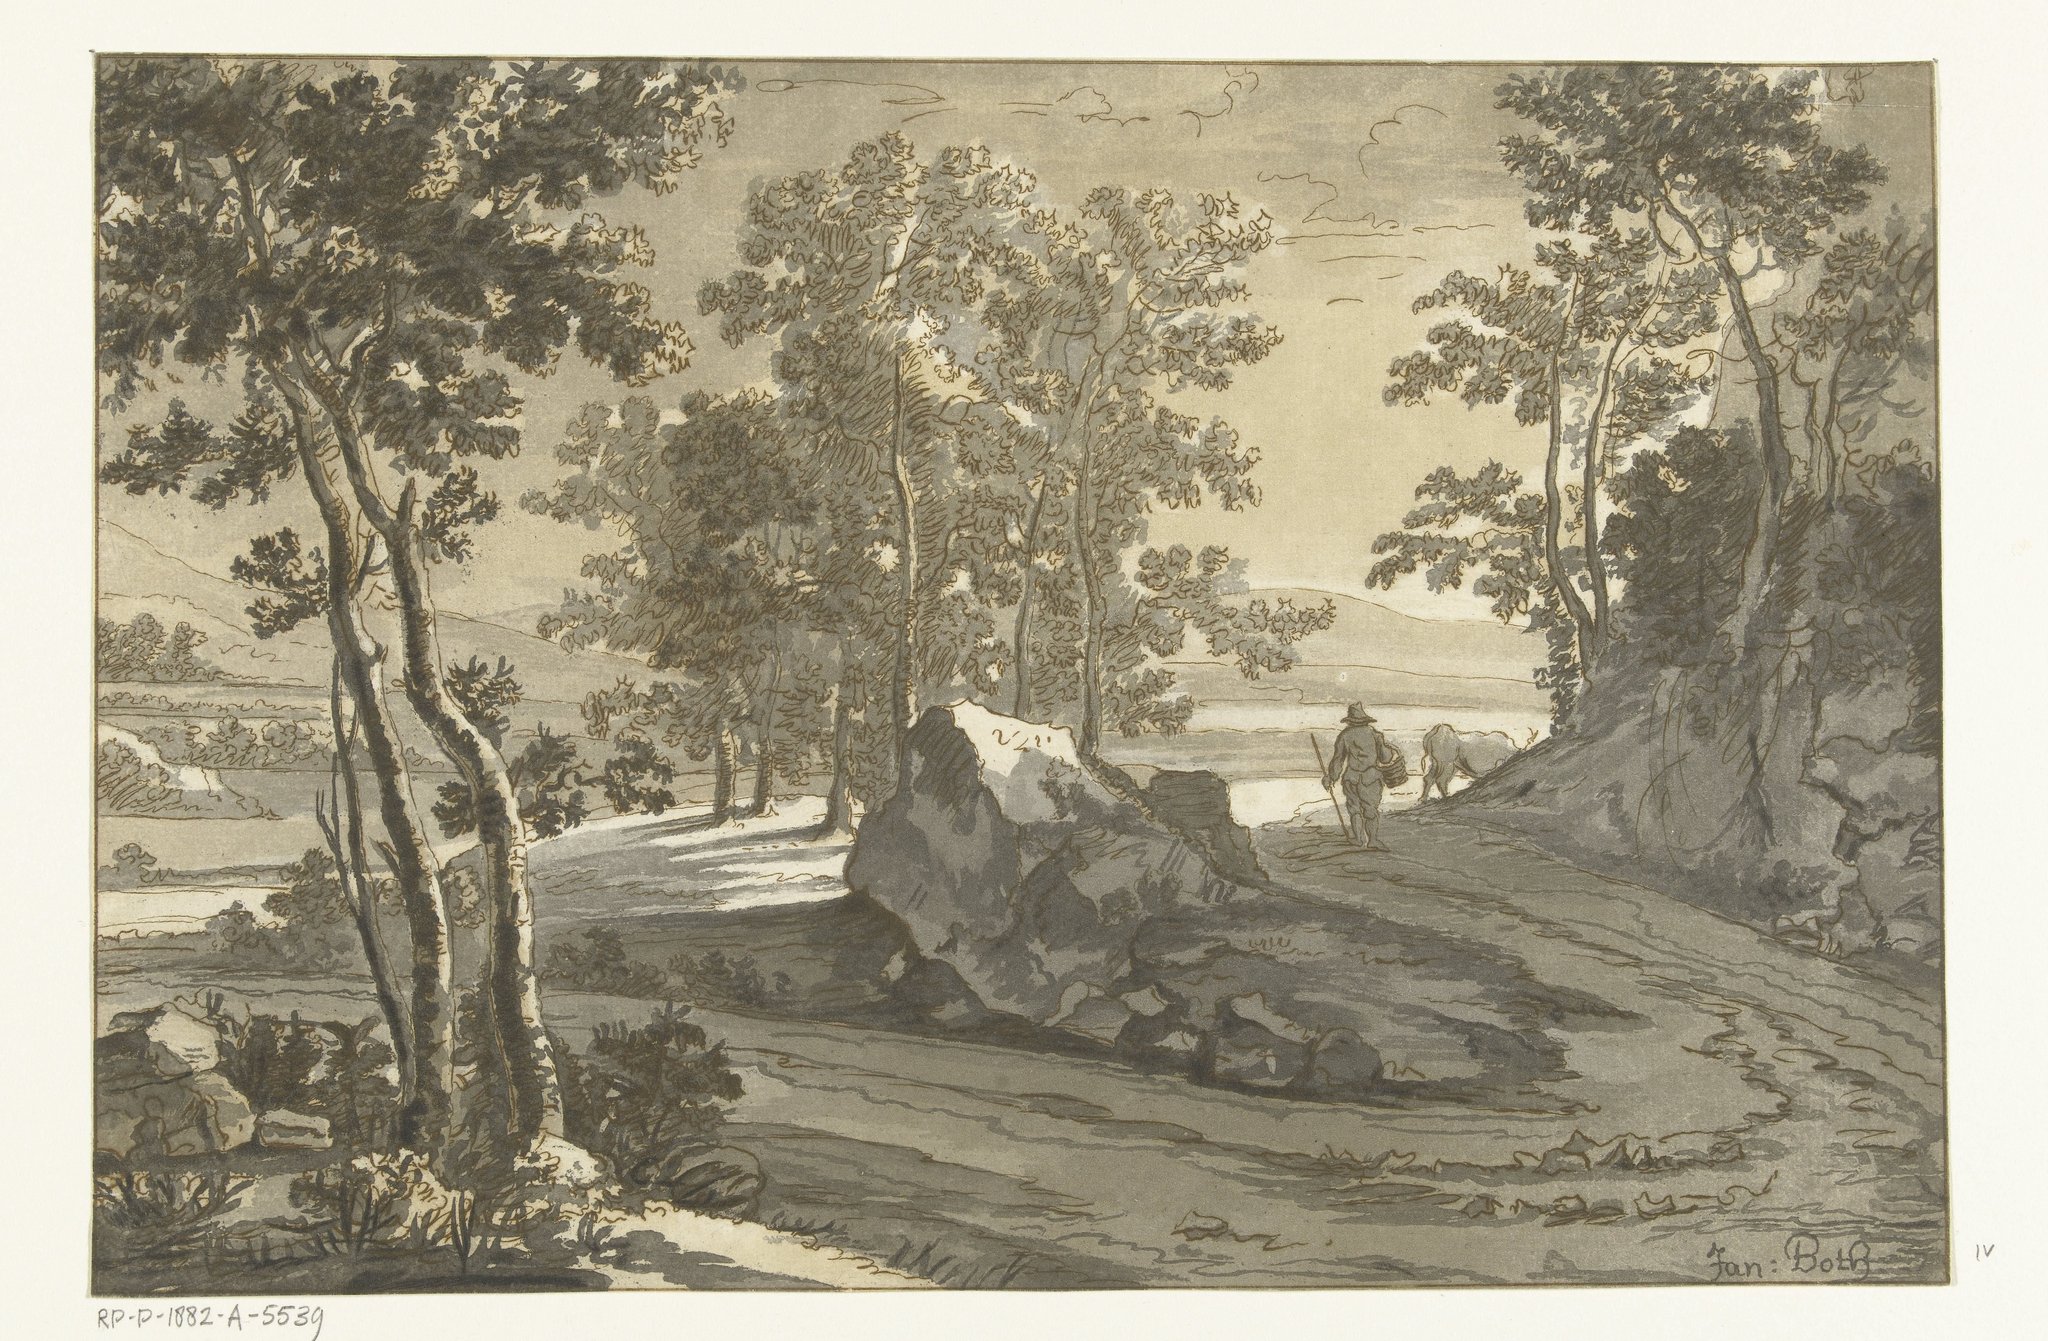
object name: print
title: Boomrijk landschap met veedrijver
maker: cornelis brouwer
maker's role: print maker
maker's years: 1731-1803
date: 1741-1803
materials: paper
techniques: aquatint, etching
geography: netherlands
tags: low hill country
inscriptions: collector's mark: Lugt 2228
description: Prent naar tekening van Jan Both gedrukt met twee platen. Prent uit serie van negen prenttekeningen met acht landschappen en een zeegezicht naar Hollandse meesters uit de 17e eeuw, zie Huffel 1921, p. 33-35.